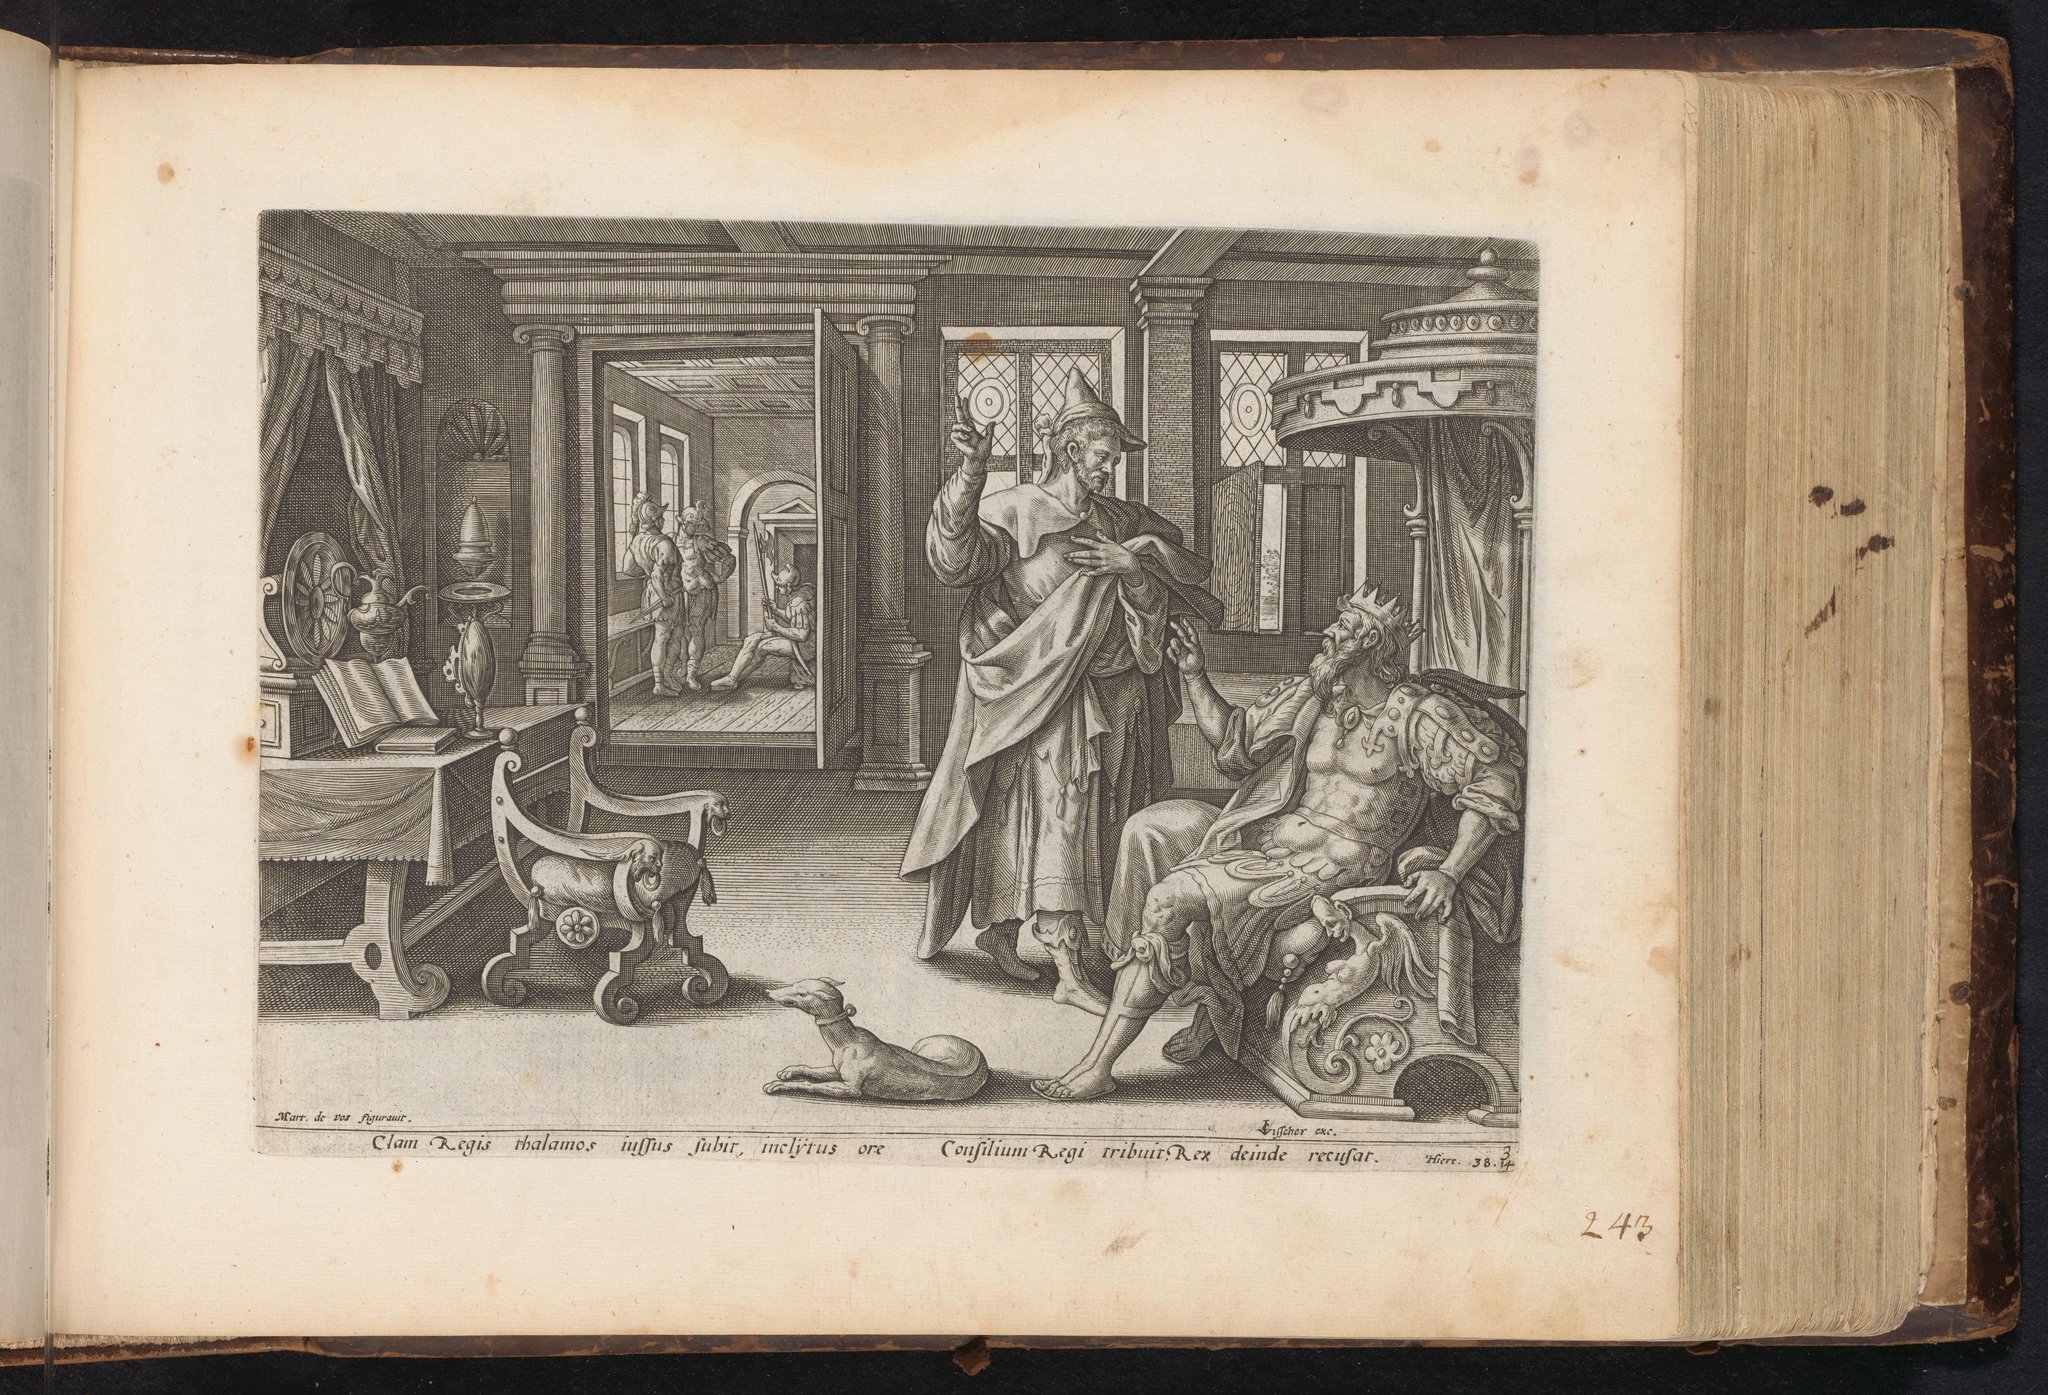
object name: print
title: Van den Propheet Ieremias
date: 1585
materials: paper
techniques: engraving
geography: alkmaar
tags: jeremiah before zedekiah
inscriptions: number: ‘243’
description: Koning Sedekia vraagt aan Jeremia wat God aan hem heeft geopenbaard. Onder de voorstelling een verwijzing in het Latijn naar de Bijbeltekst in Jer. 38:14. Deze prent maakt deel uit van een album.